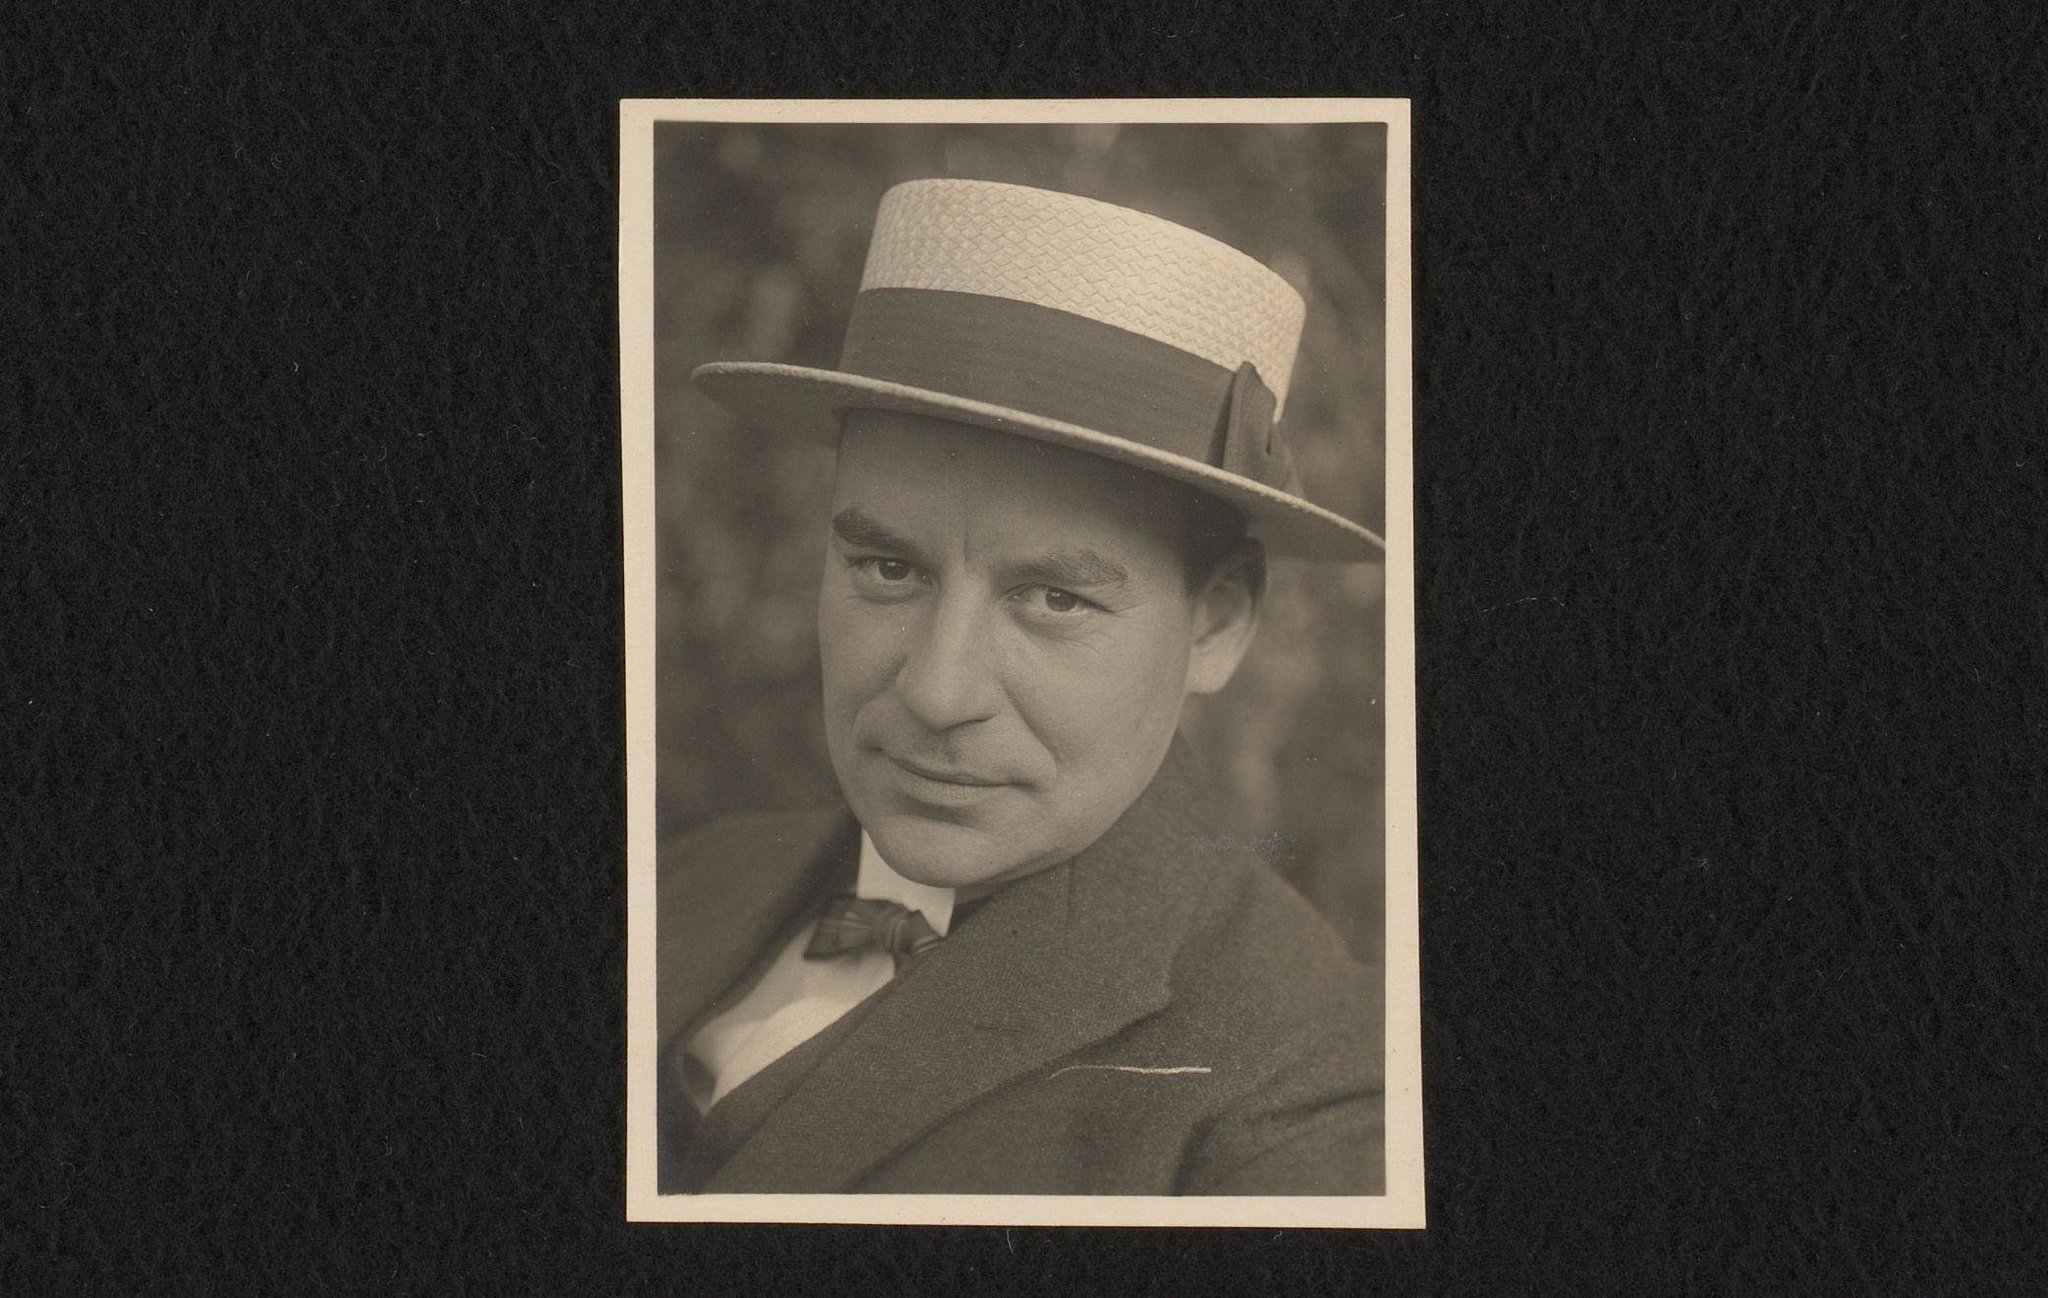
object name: album leaf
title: Portret van Frederik (Frits) Stokhuyzen met hoed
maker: frederik stokhuyzen (frits)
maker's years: 1890-1976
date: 1924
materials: paper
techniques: gelatin silver print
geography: oegstgeest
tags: frederik stokhuyzen (frits), historical persons, head-gear: hat